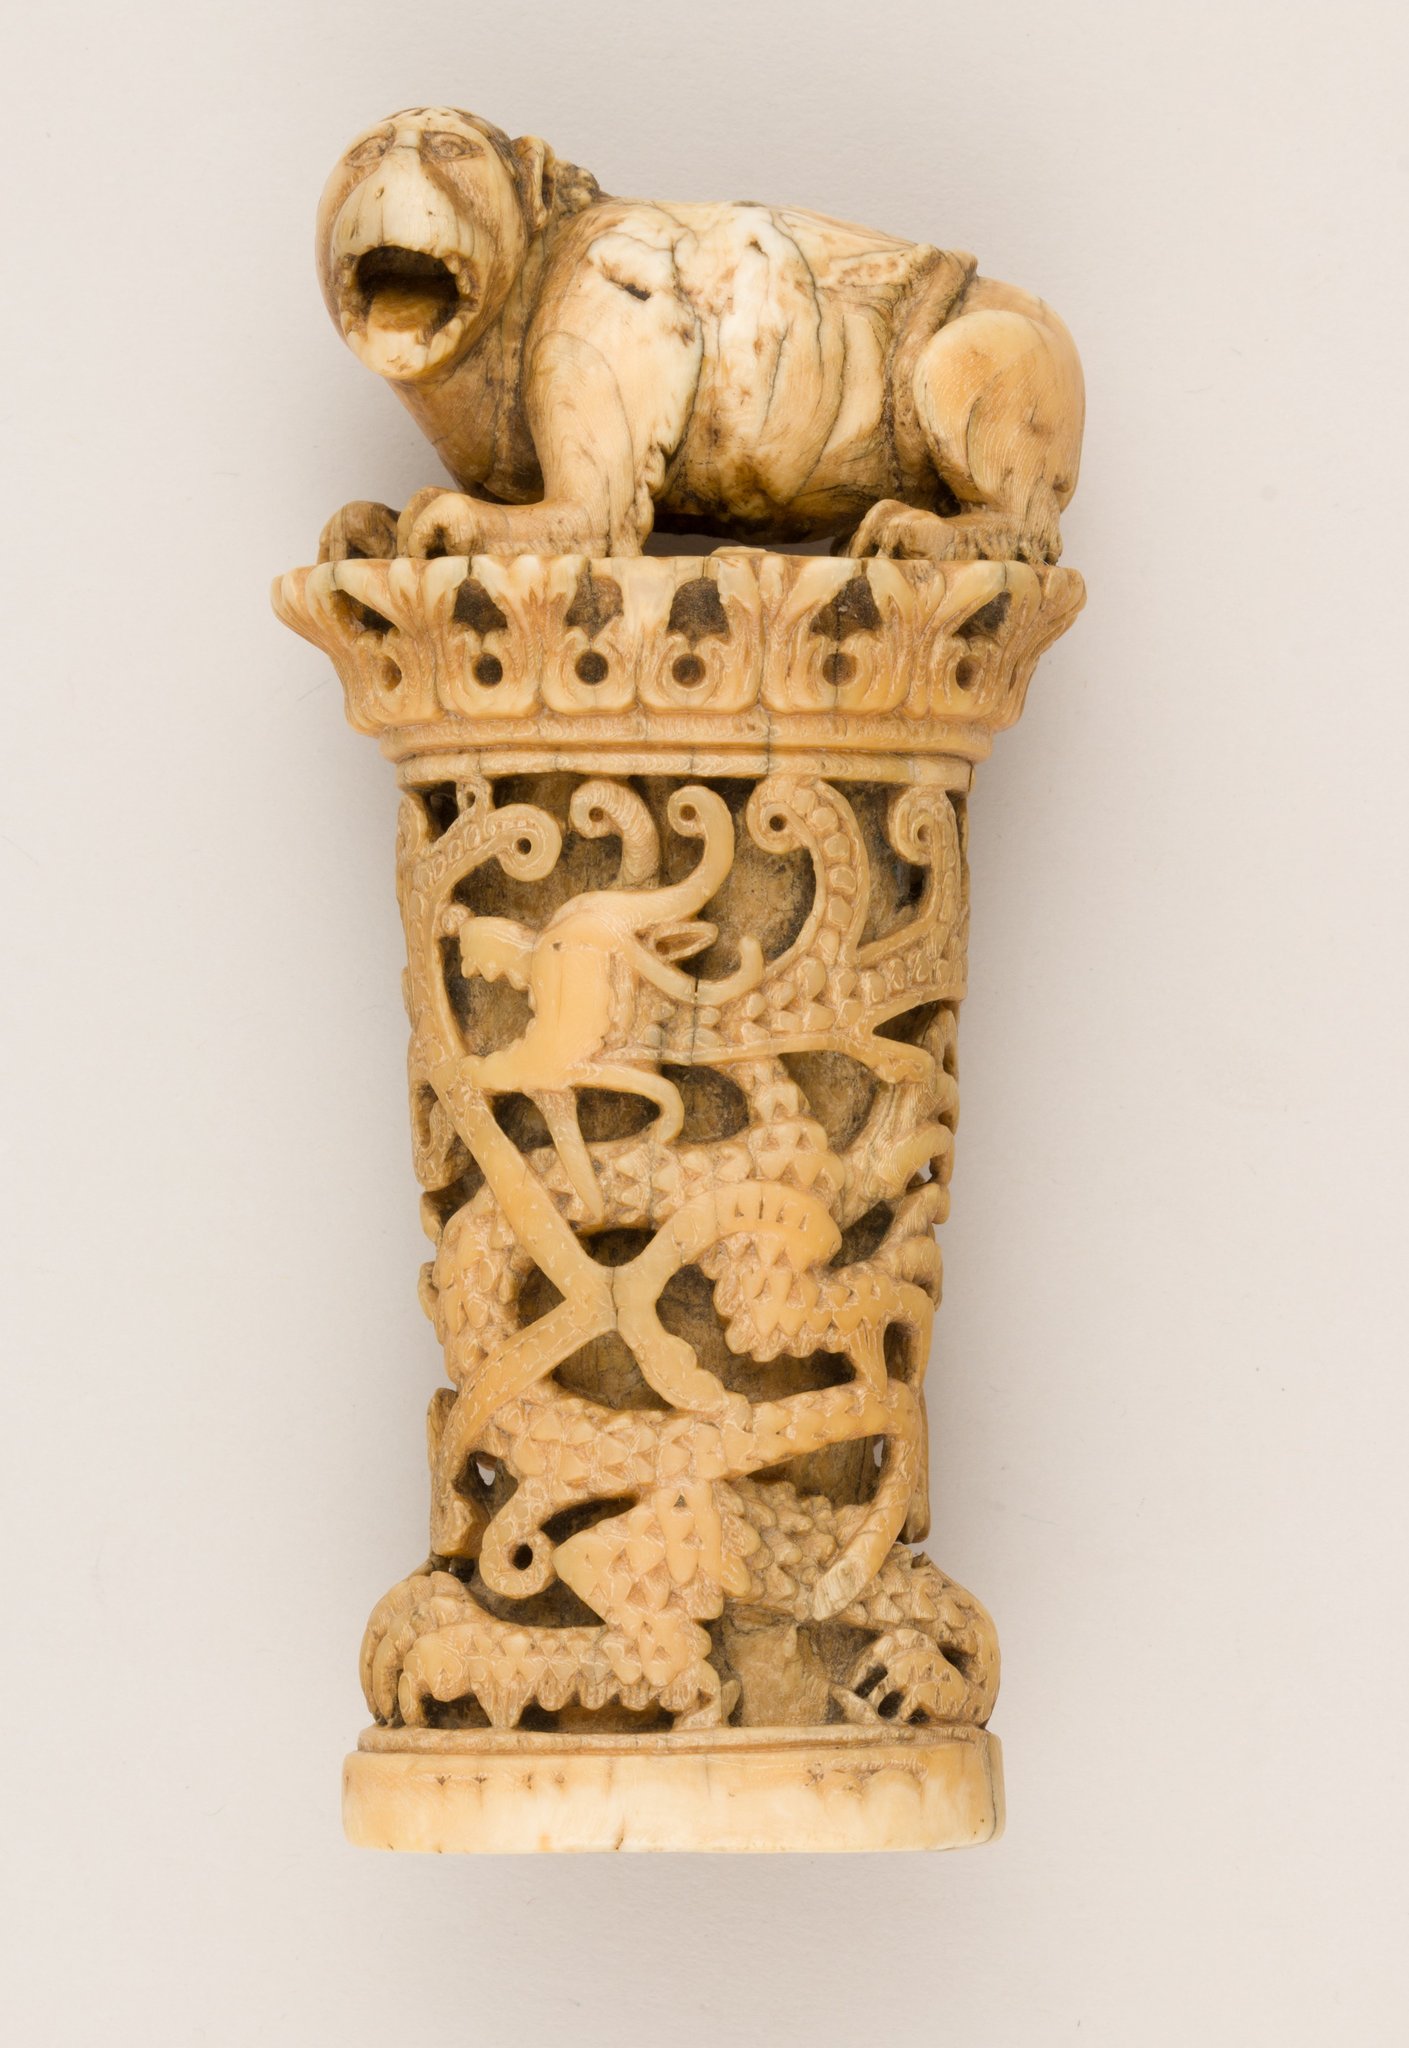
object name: dagger hilt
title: Hilt of a Dagger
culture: italian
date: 1300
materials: ivory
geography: italy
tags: animals,dragons